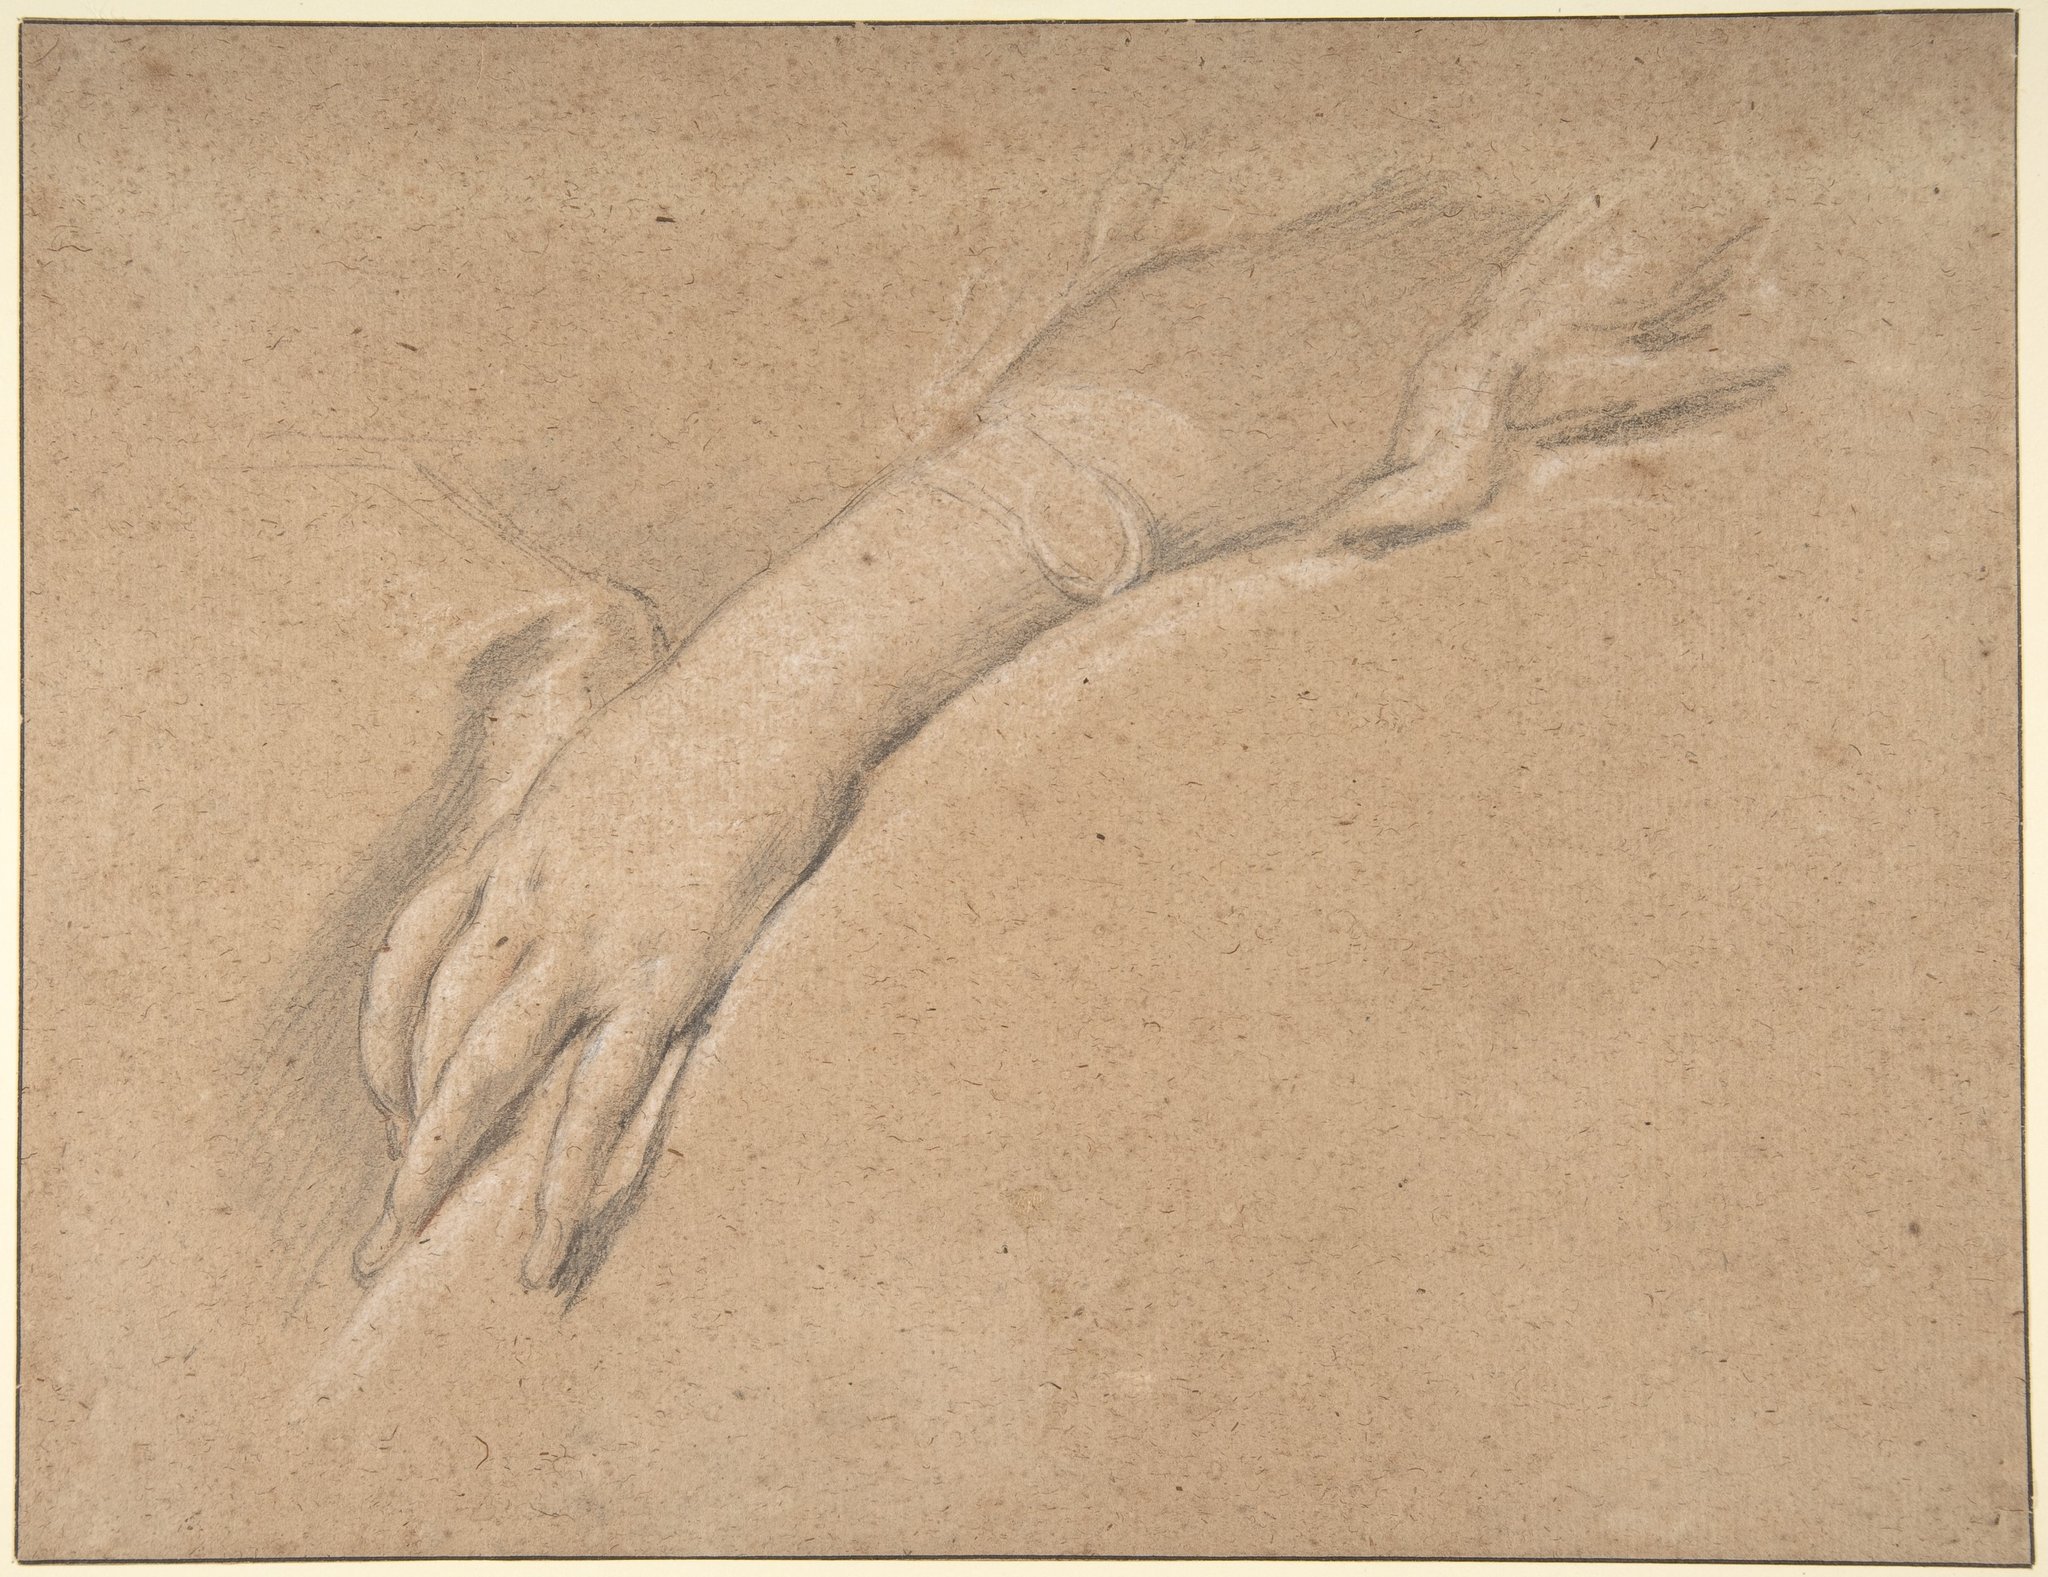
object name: drawing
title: Study of the left hand of Mme de Pompadour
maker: françois boucher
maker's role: artist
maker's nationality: french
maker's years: 1703-1770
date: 1701-1800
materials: chalk, ink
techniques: heightening, pen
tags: hands